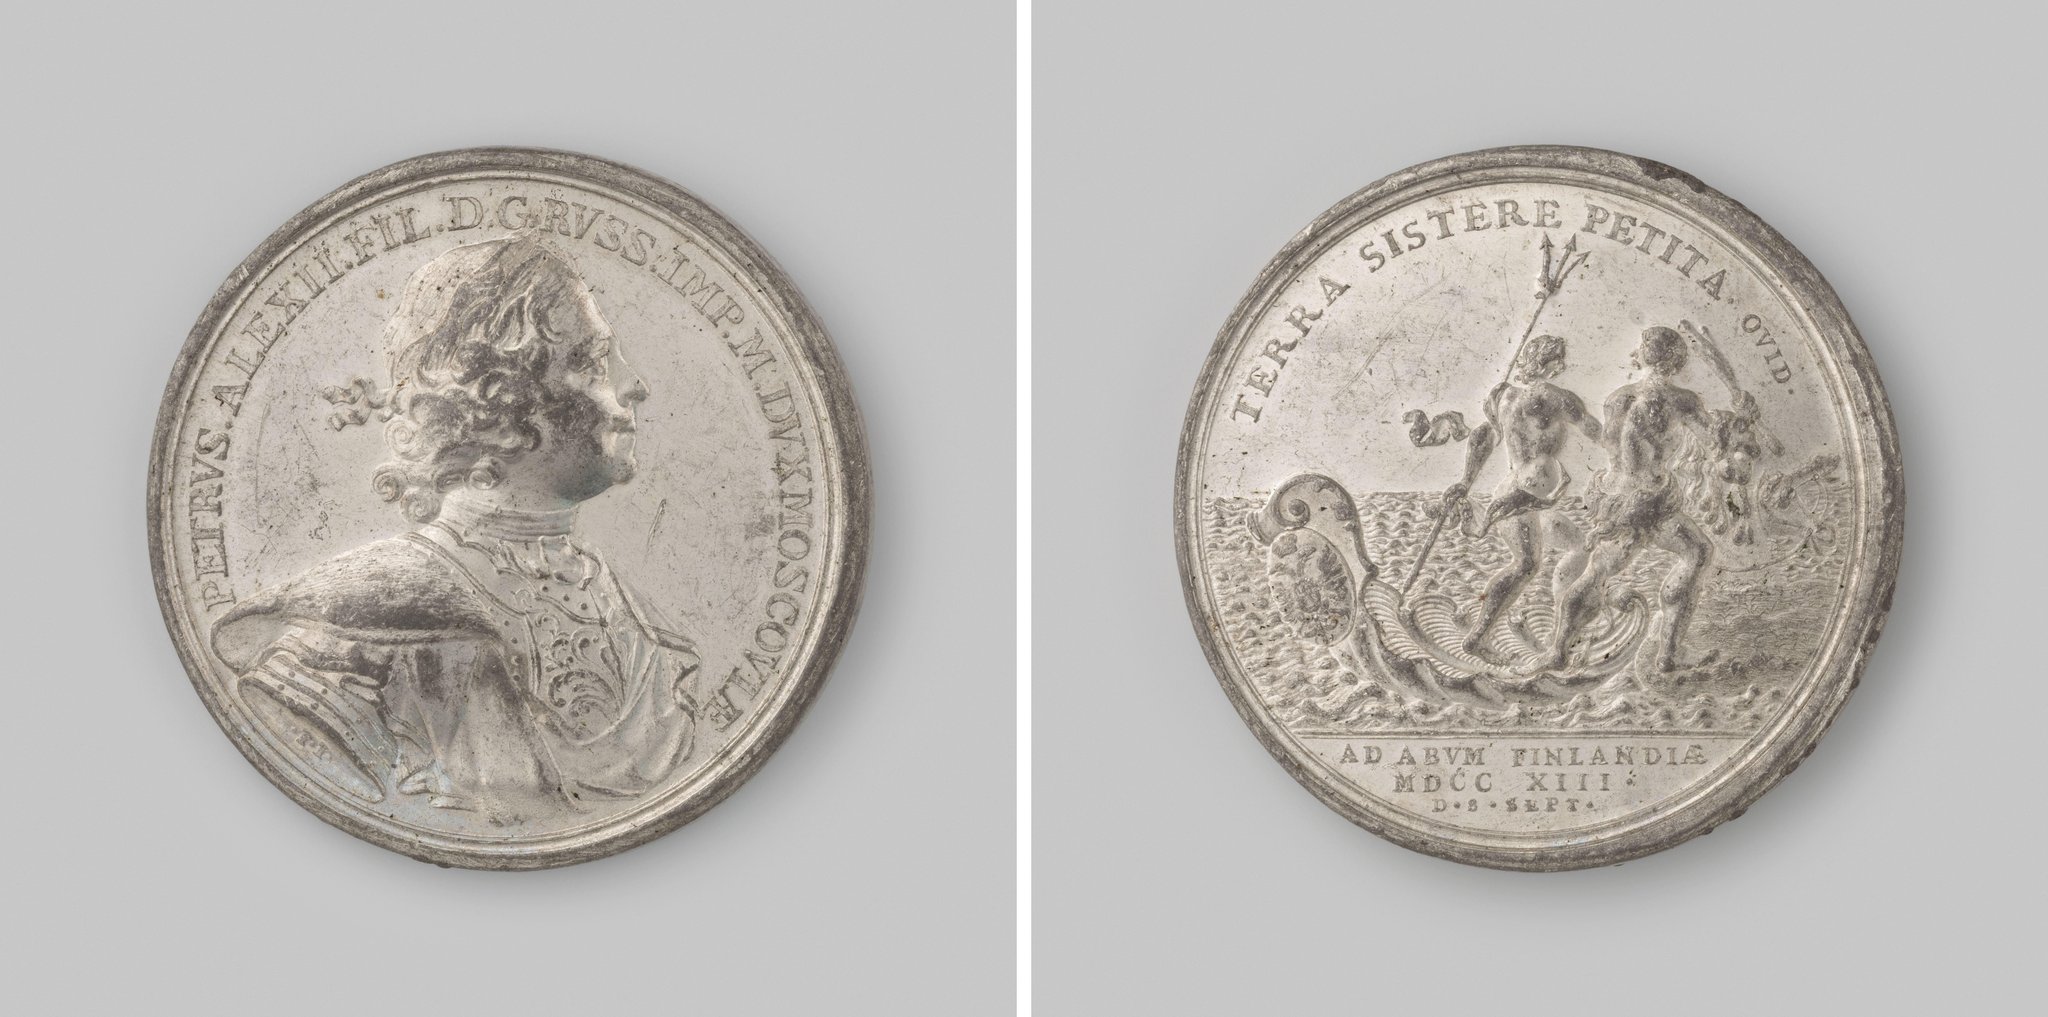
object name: history medal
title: Overwinning van Rusland op Zweden aan de Pelkin 1713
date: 1713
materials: tin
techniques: striking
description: Tinnen penning, op de voorzijde het borstbeeld van Tsaar Peter de Grote naar rechts met omschrift, op de keerzijde een plattegrond met de Pelkin met rechts een soldaat en een riviergod en boven een banderol, met afsnedetekst.